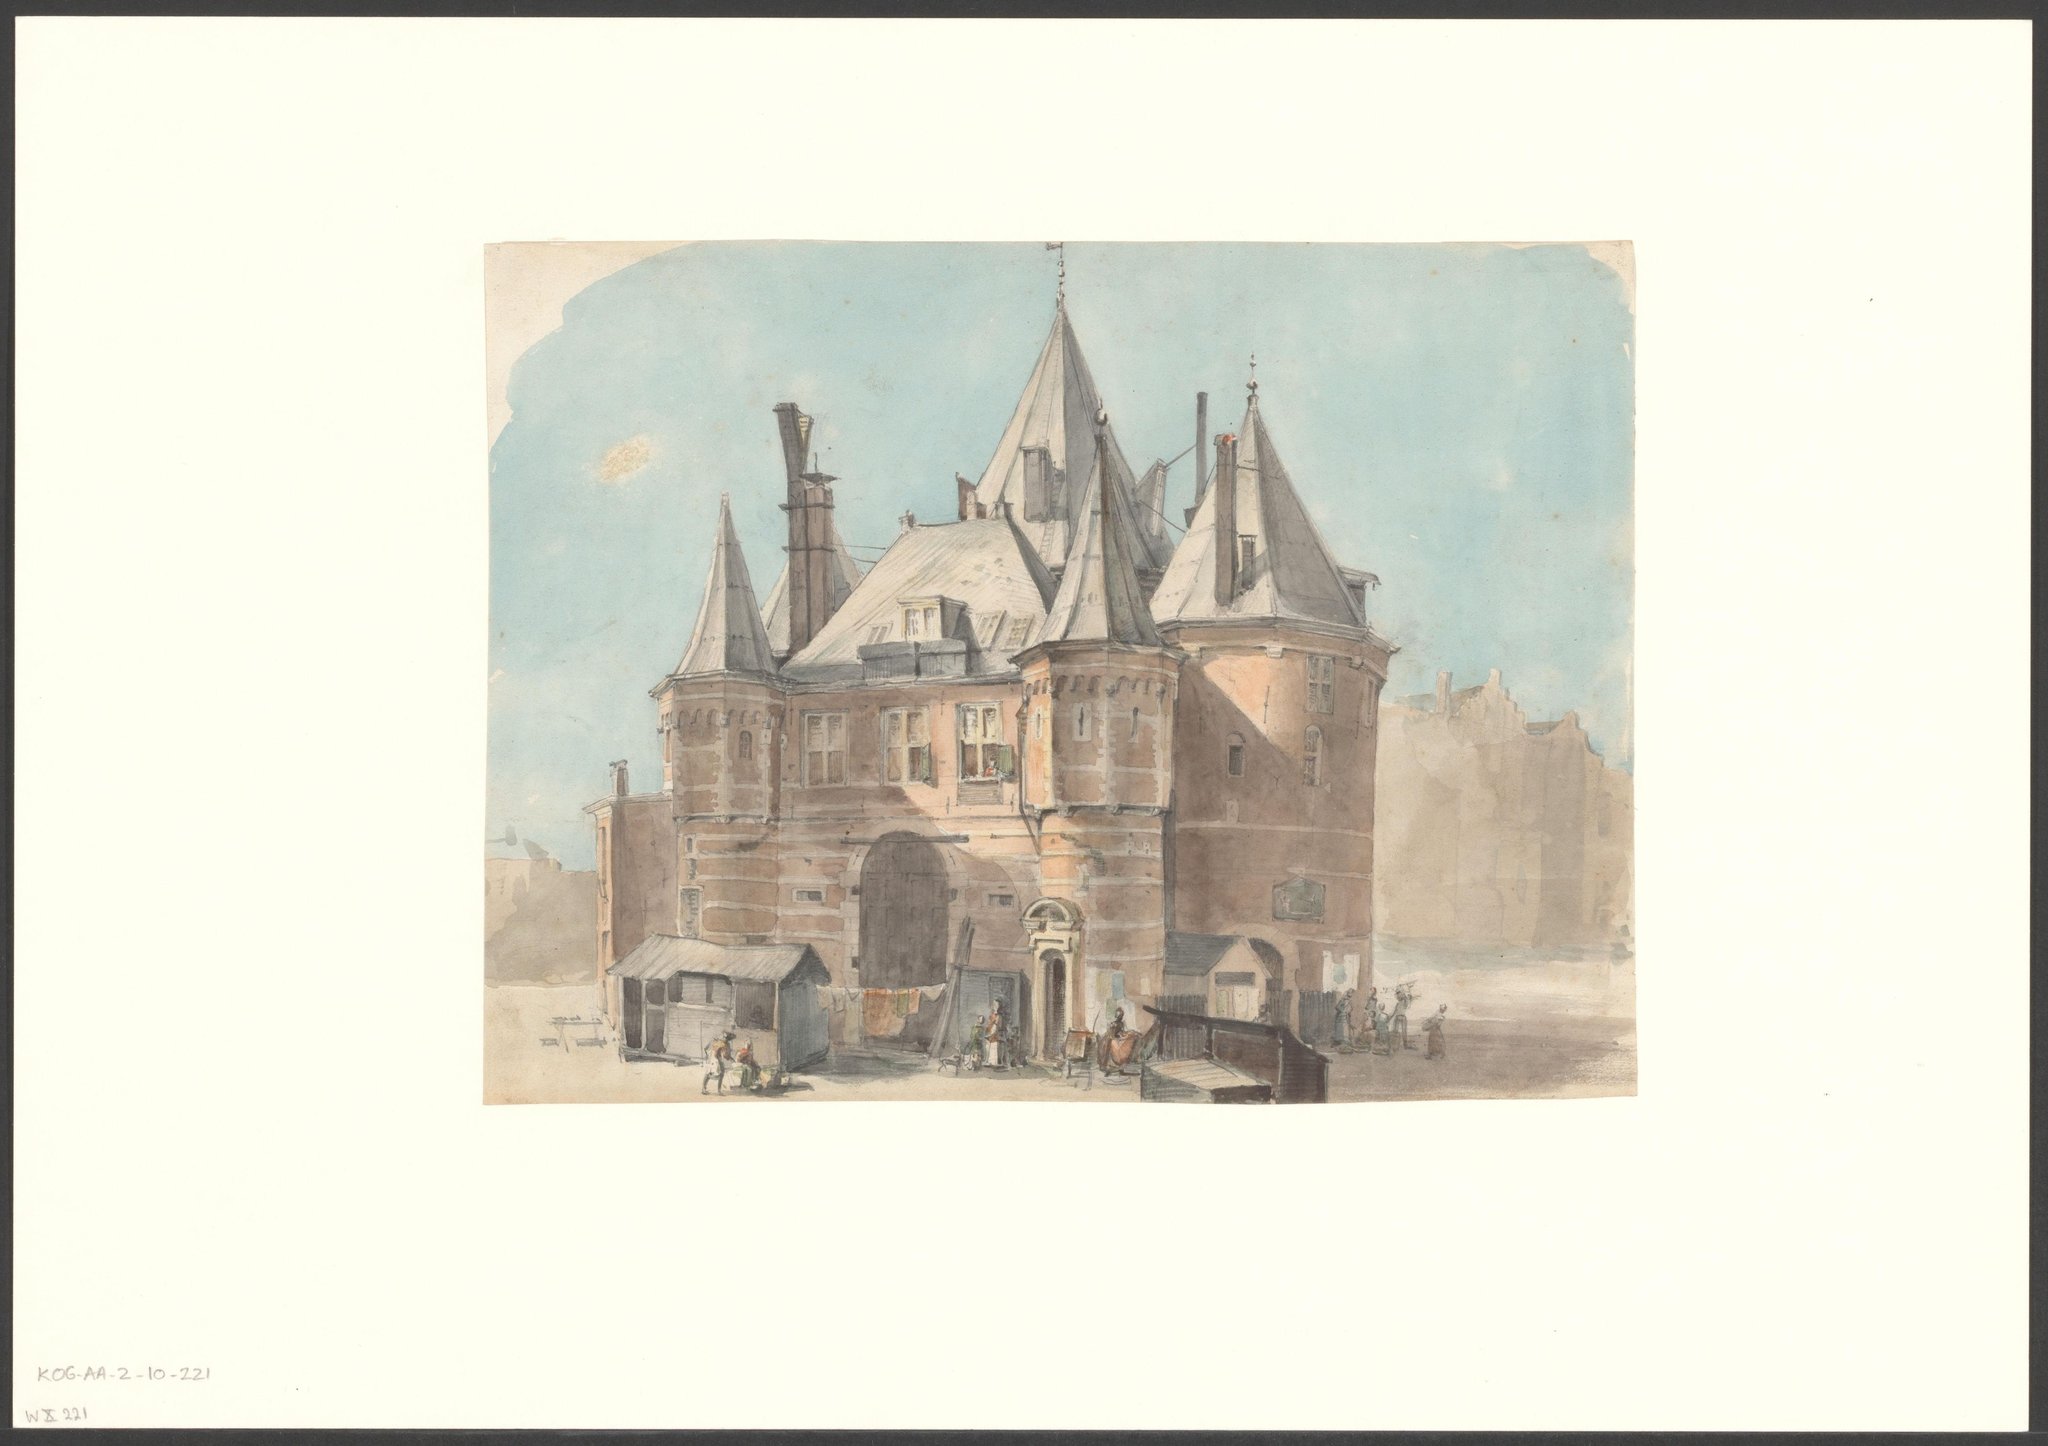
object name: drawing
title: Gezicht op de Nieuwmarkt en de Waag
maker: s.j.h. van der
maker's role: draughtsman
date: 1800-1899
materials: paper, pencil, watercolor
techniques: brush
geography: amsterdam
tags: city-view, and landscape with man-made constructions, weigh-house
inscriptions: collector's mark: Lugt 800a, name: ‘SJH van der Noorda.’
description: Tekening binnen de Atlas Van Eck ingedeeld op wijknummer 10.